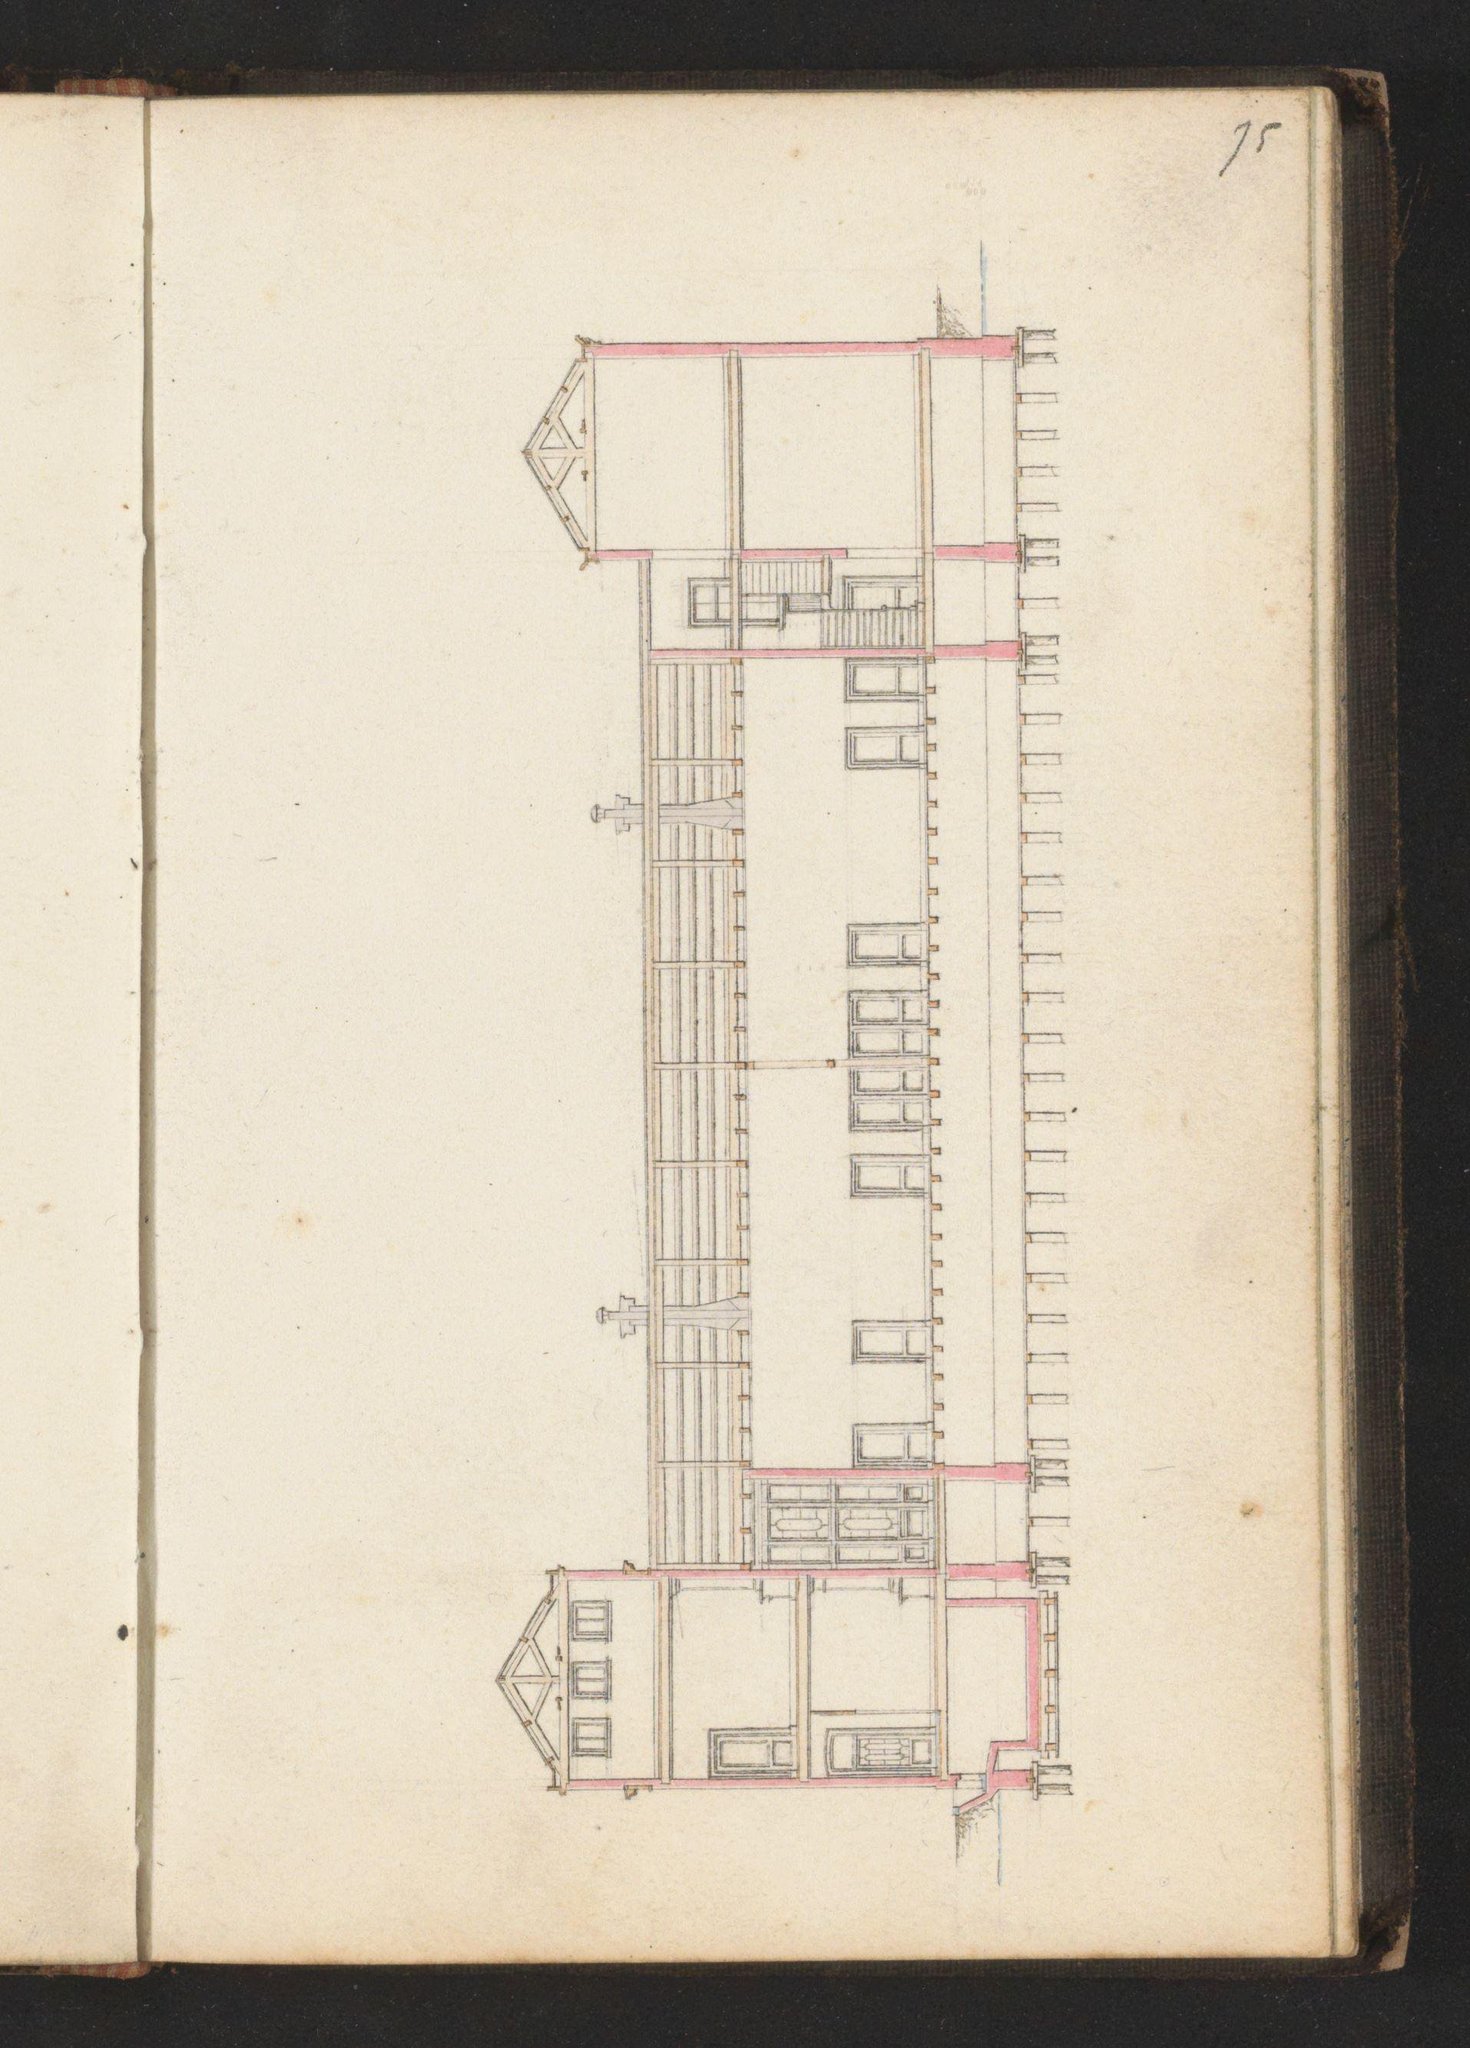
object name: sketchbook leaf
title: Doorsnede van een gebouw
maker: willem springer jr.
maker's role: draughtsman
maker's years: 1815-1907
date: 1864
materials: ink, paper, pencil, watercolor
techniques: brush, pen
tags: section ~ architectural design or model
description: Pagina 75 uit een schetsboek met 164 pagina's.